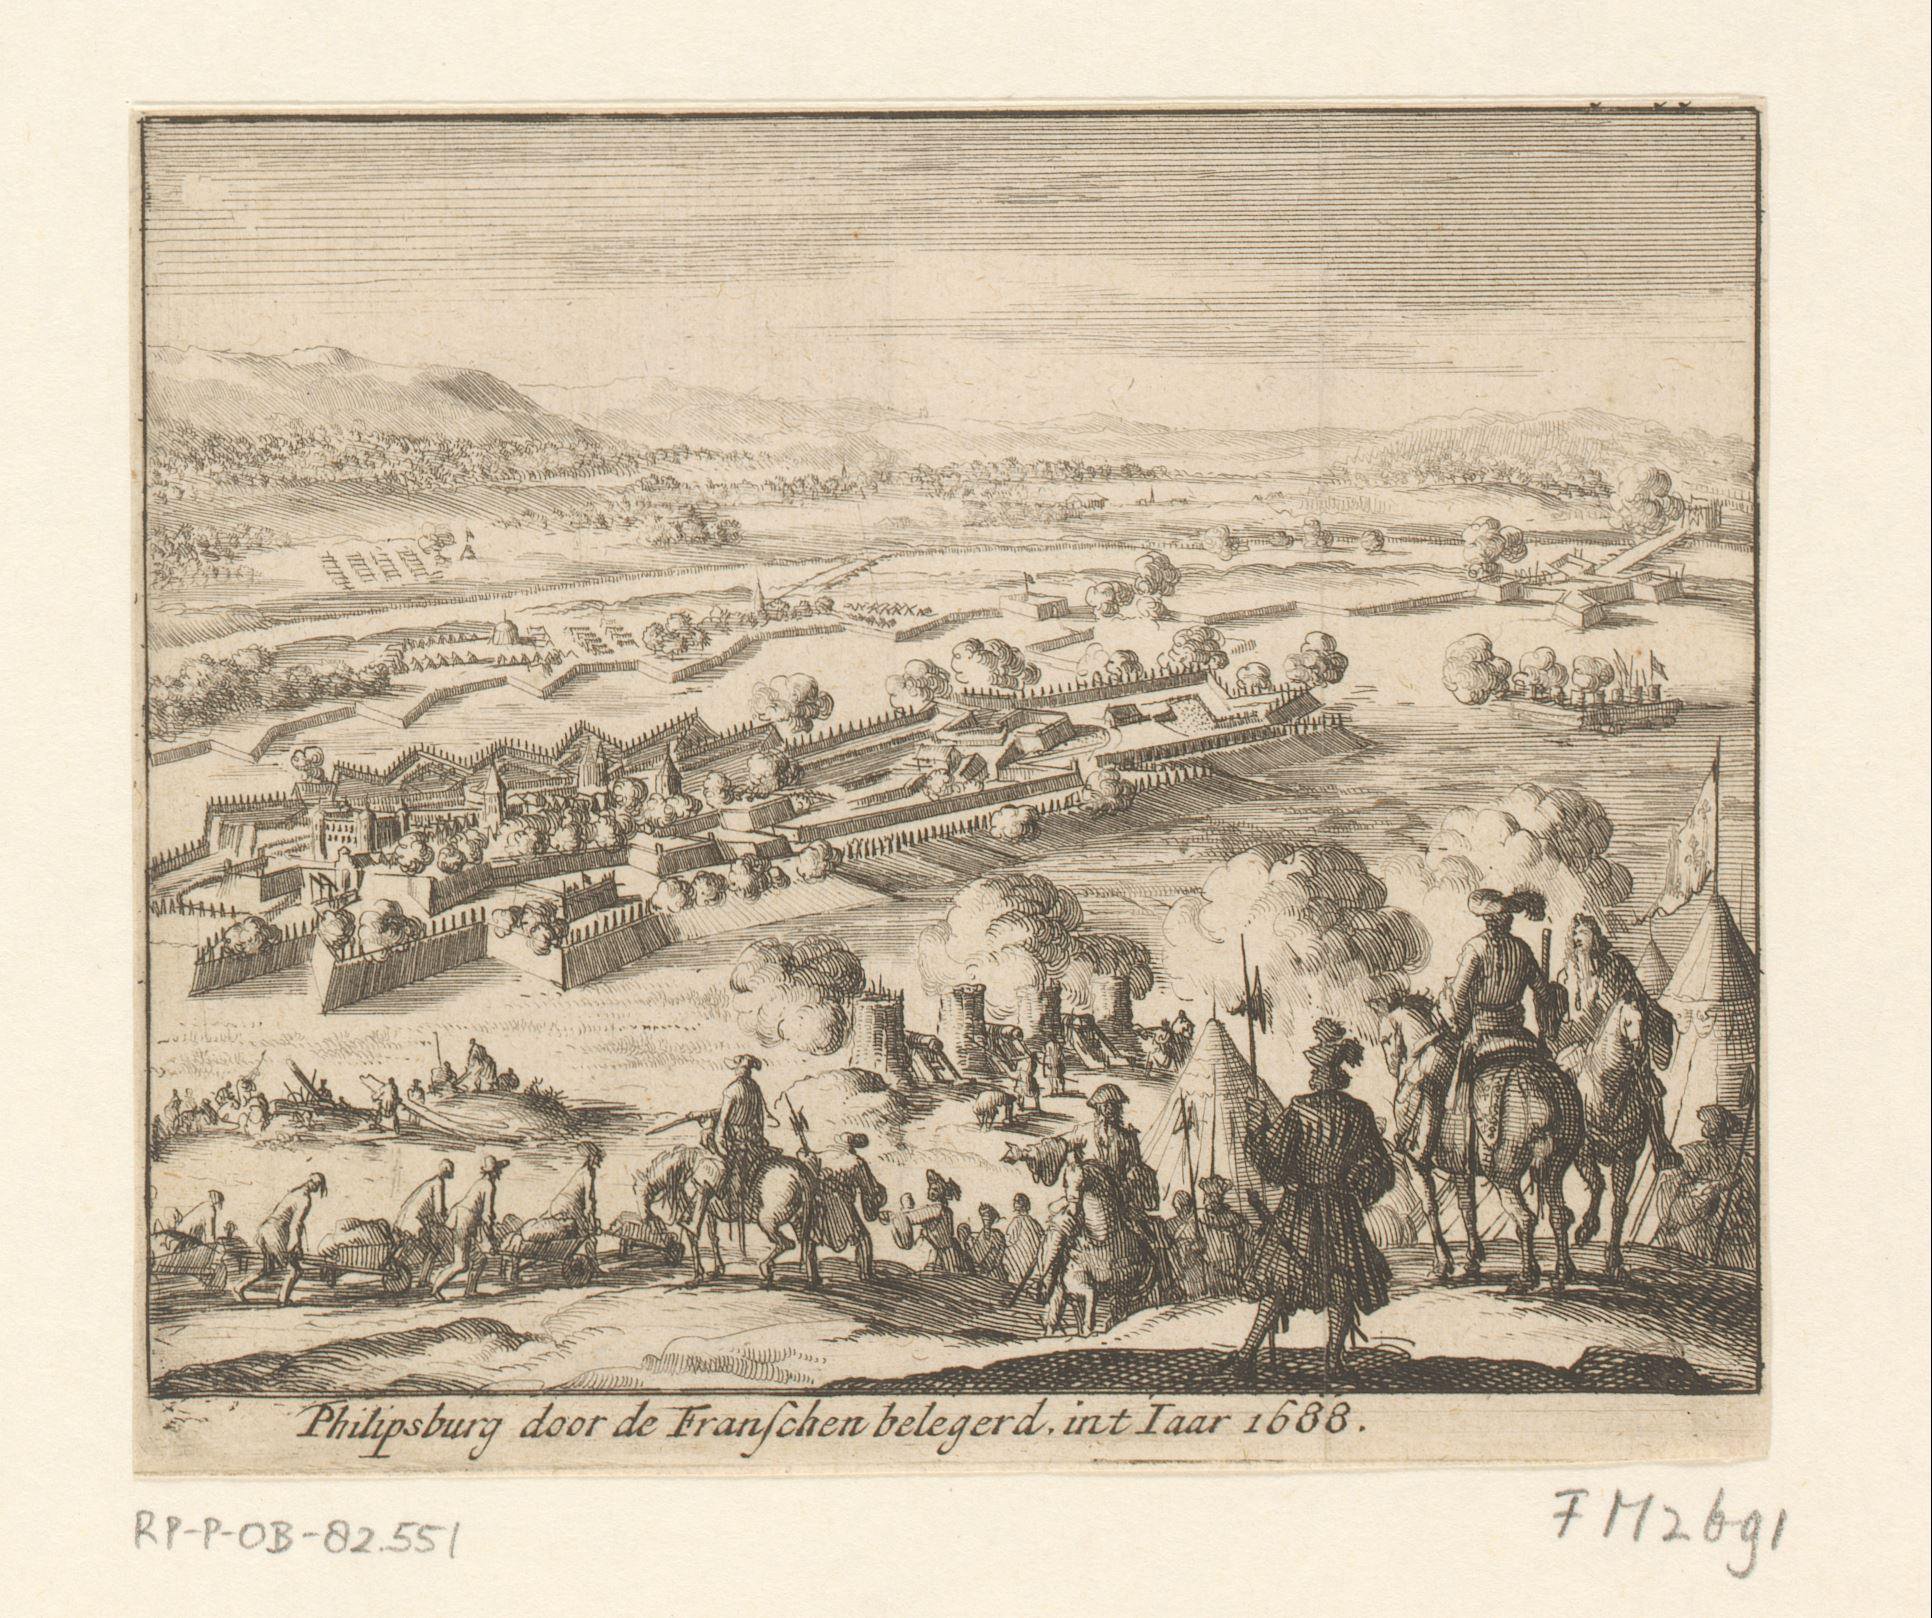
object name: history print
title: Philipsburg door de Franschen belegerd, in 't Jaar 1688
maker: jan luyken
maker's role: draughtsman, print maker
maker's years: 1649-1712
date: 1687-1689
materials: paper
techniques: etching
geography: northern netherlands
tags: siege, position war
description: Beleg van Philippsburg door het Franse leger, 10-30 oktober 1688. Gezicht vanuit het kamp van de belegeraars op de stad.